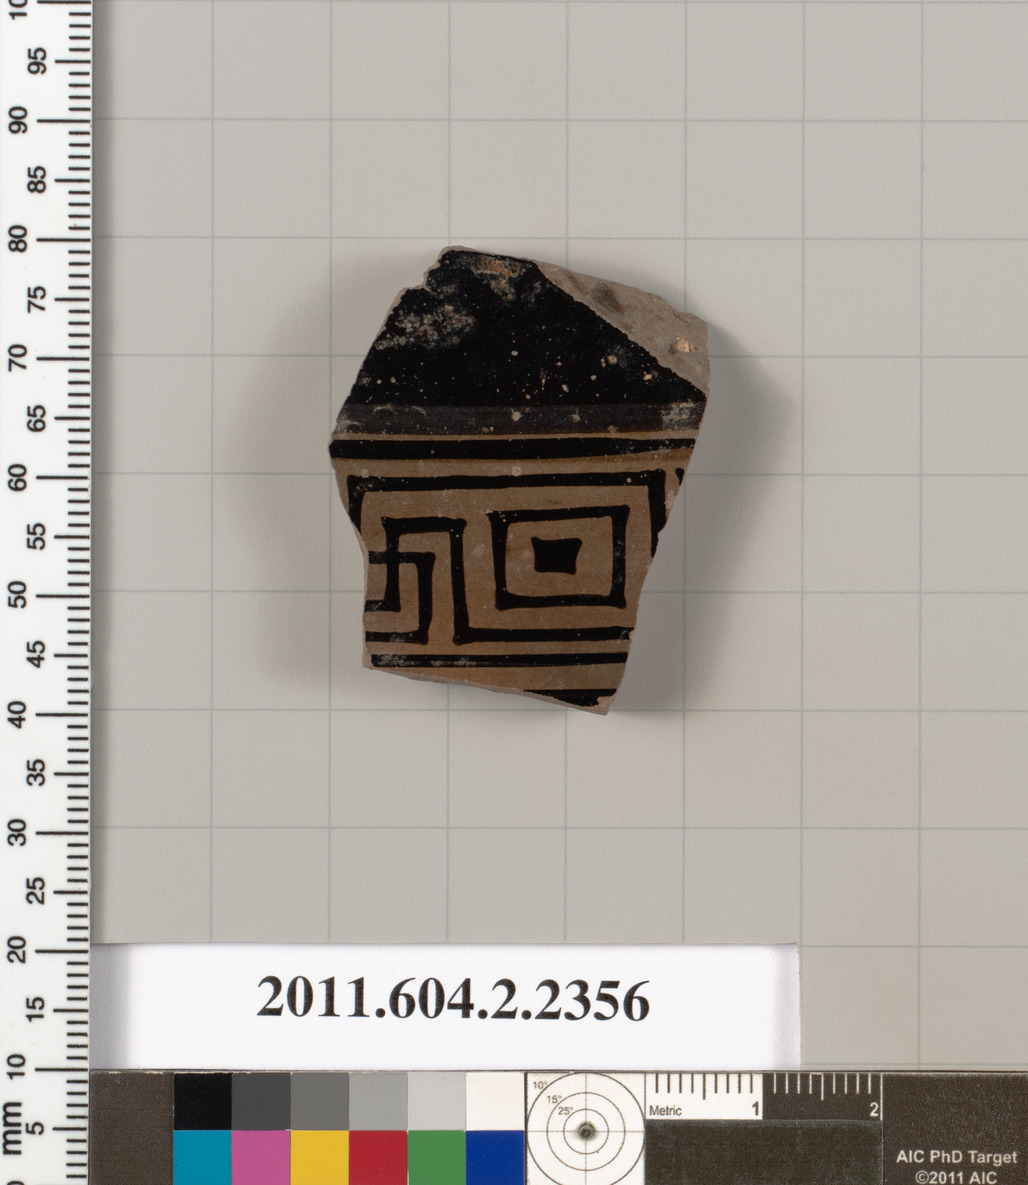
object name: pot fragment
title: Terracotta fragment of a pot; unglazed on the inside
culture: greek, attic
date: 500-480 BCE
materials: terracotta